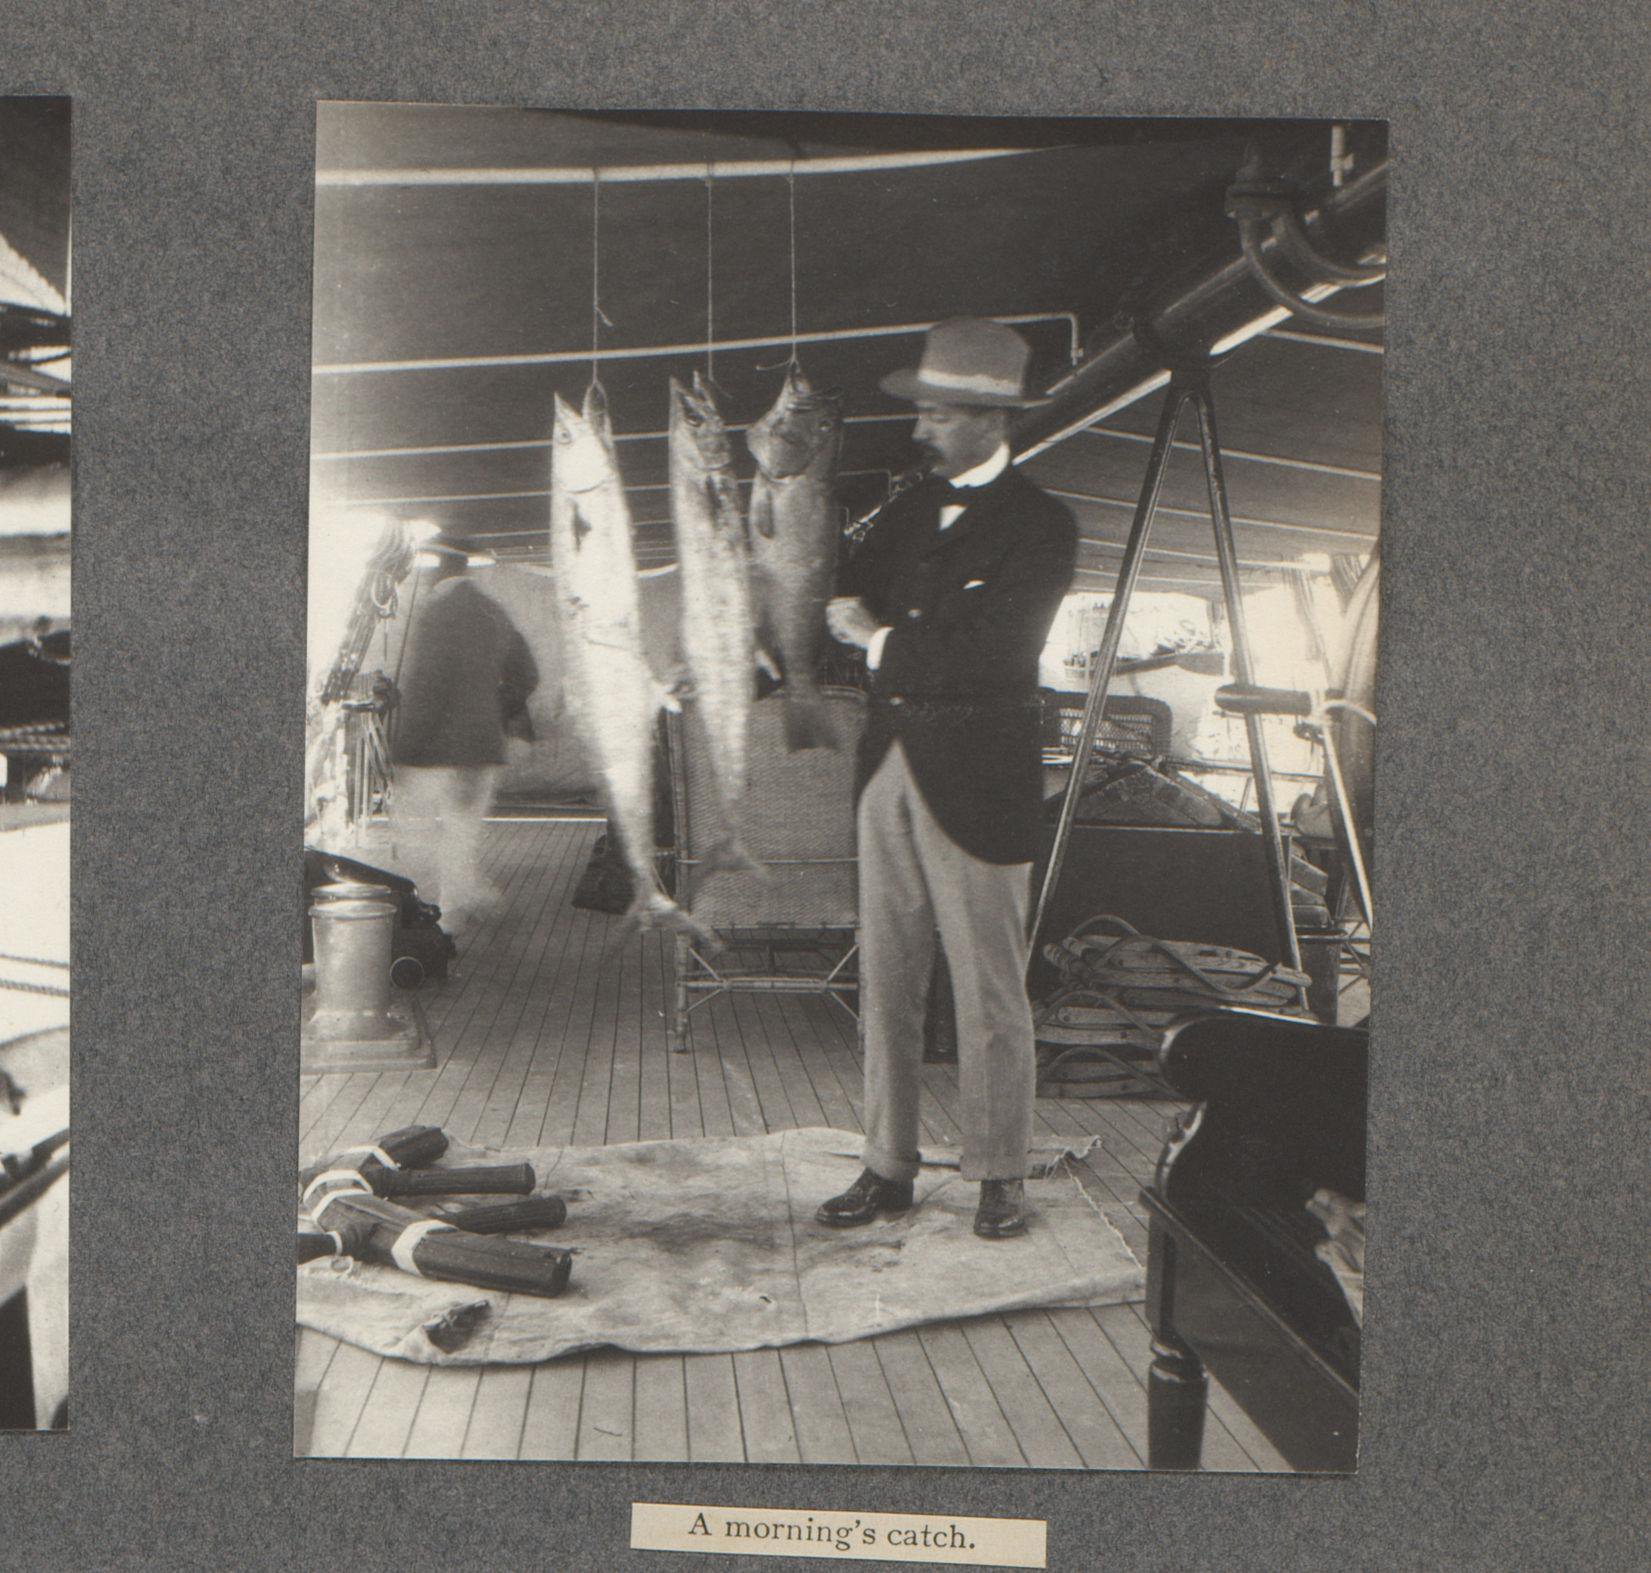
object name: album leaf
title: Man staande naast gevangen vis op het dek van de Columbia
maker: Anonymous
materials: paper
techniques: platinum process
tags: parts of ship's exterior, fisherman showing catch